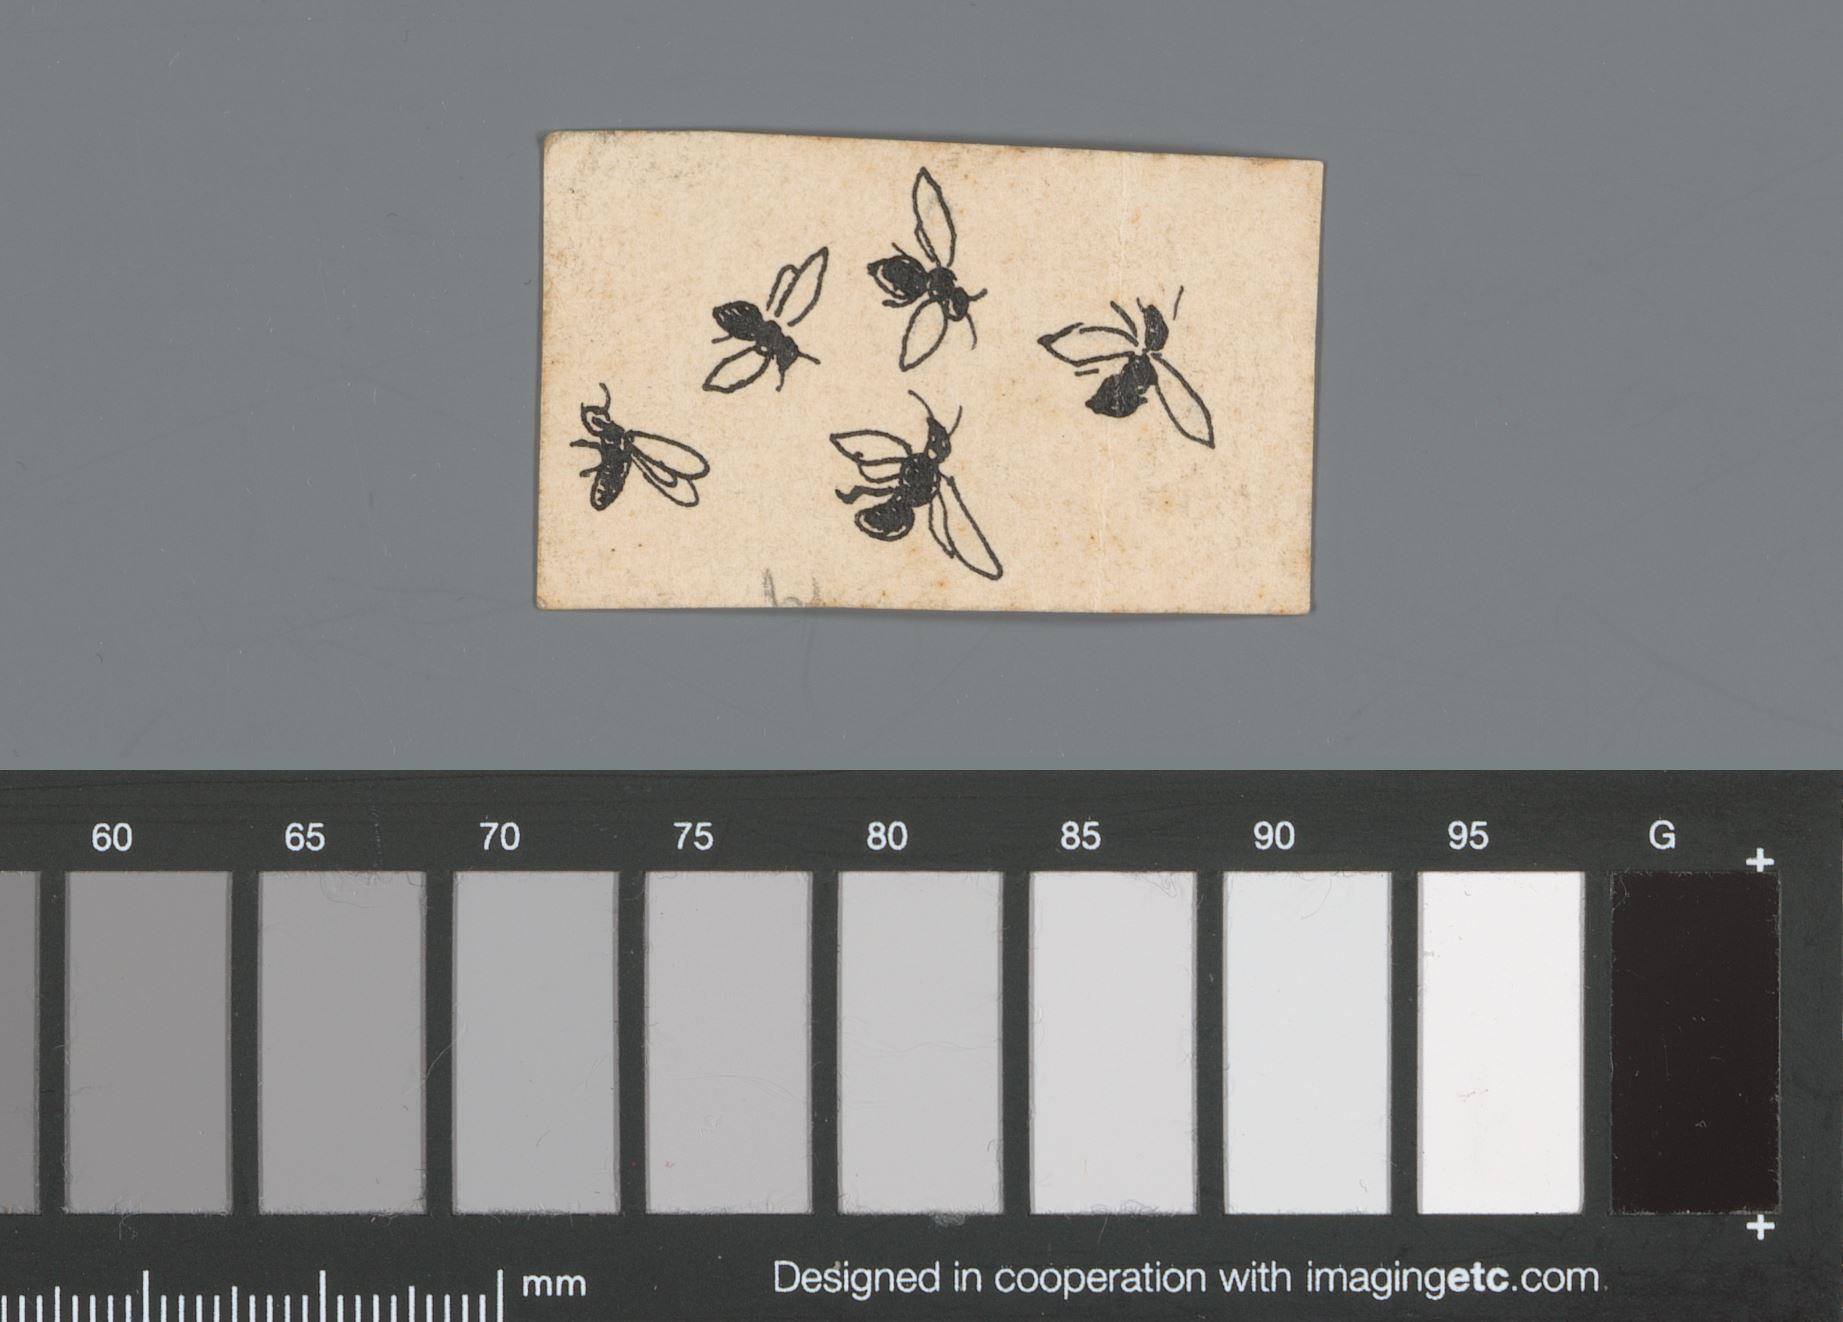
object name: boekillustratie ontwerp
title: Vijf wespen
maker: Anonymous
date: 1887-1970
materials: ink, paper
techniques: pen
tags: insects: wasp